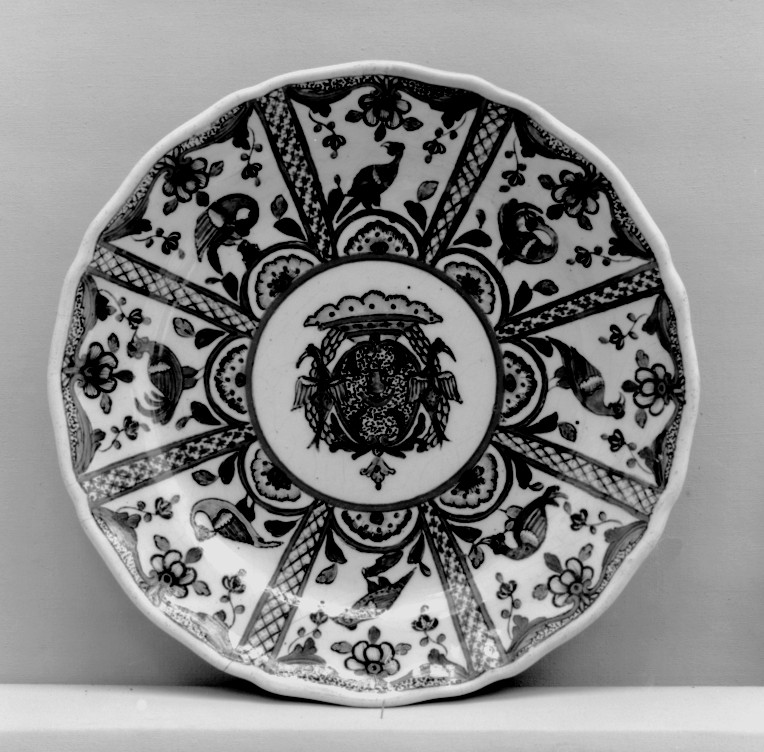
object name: plate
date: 1750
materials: faience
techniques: glazing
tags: birds,flowers,coat of arms